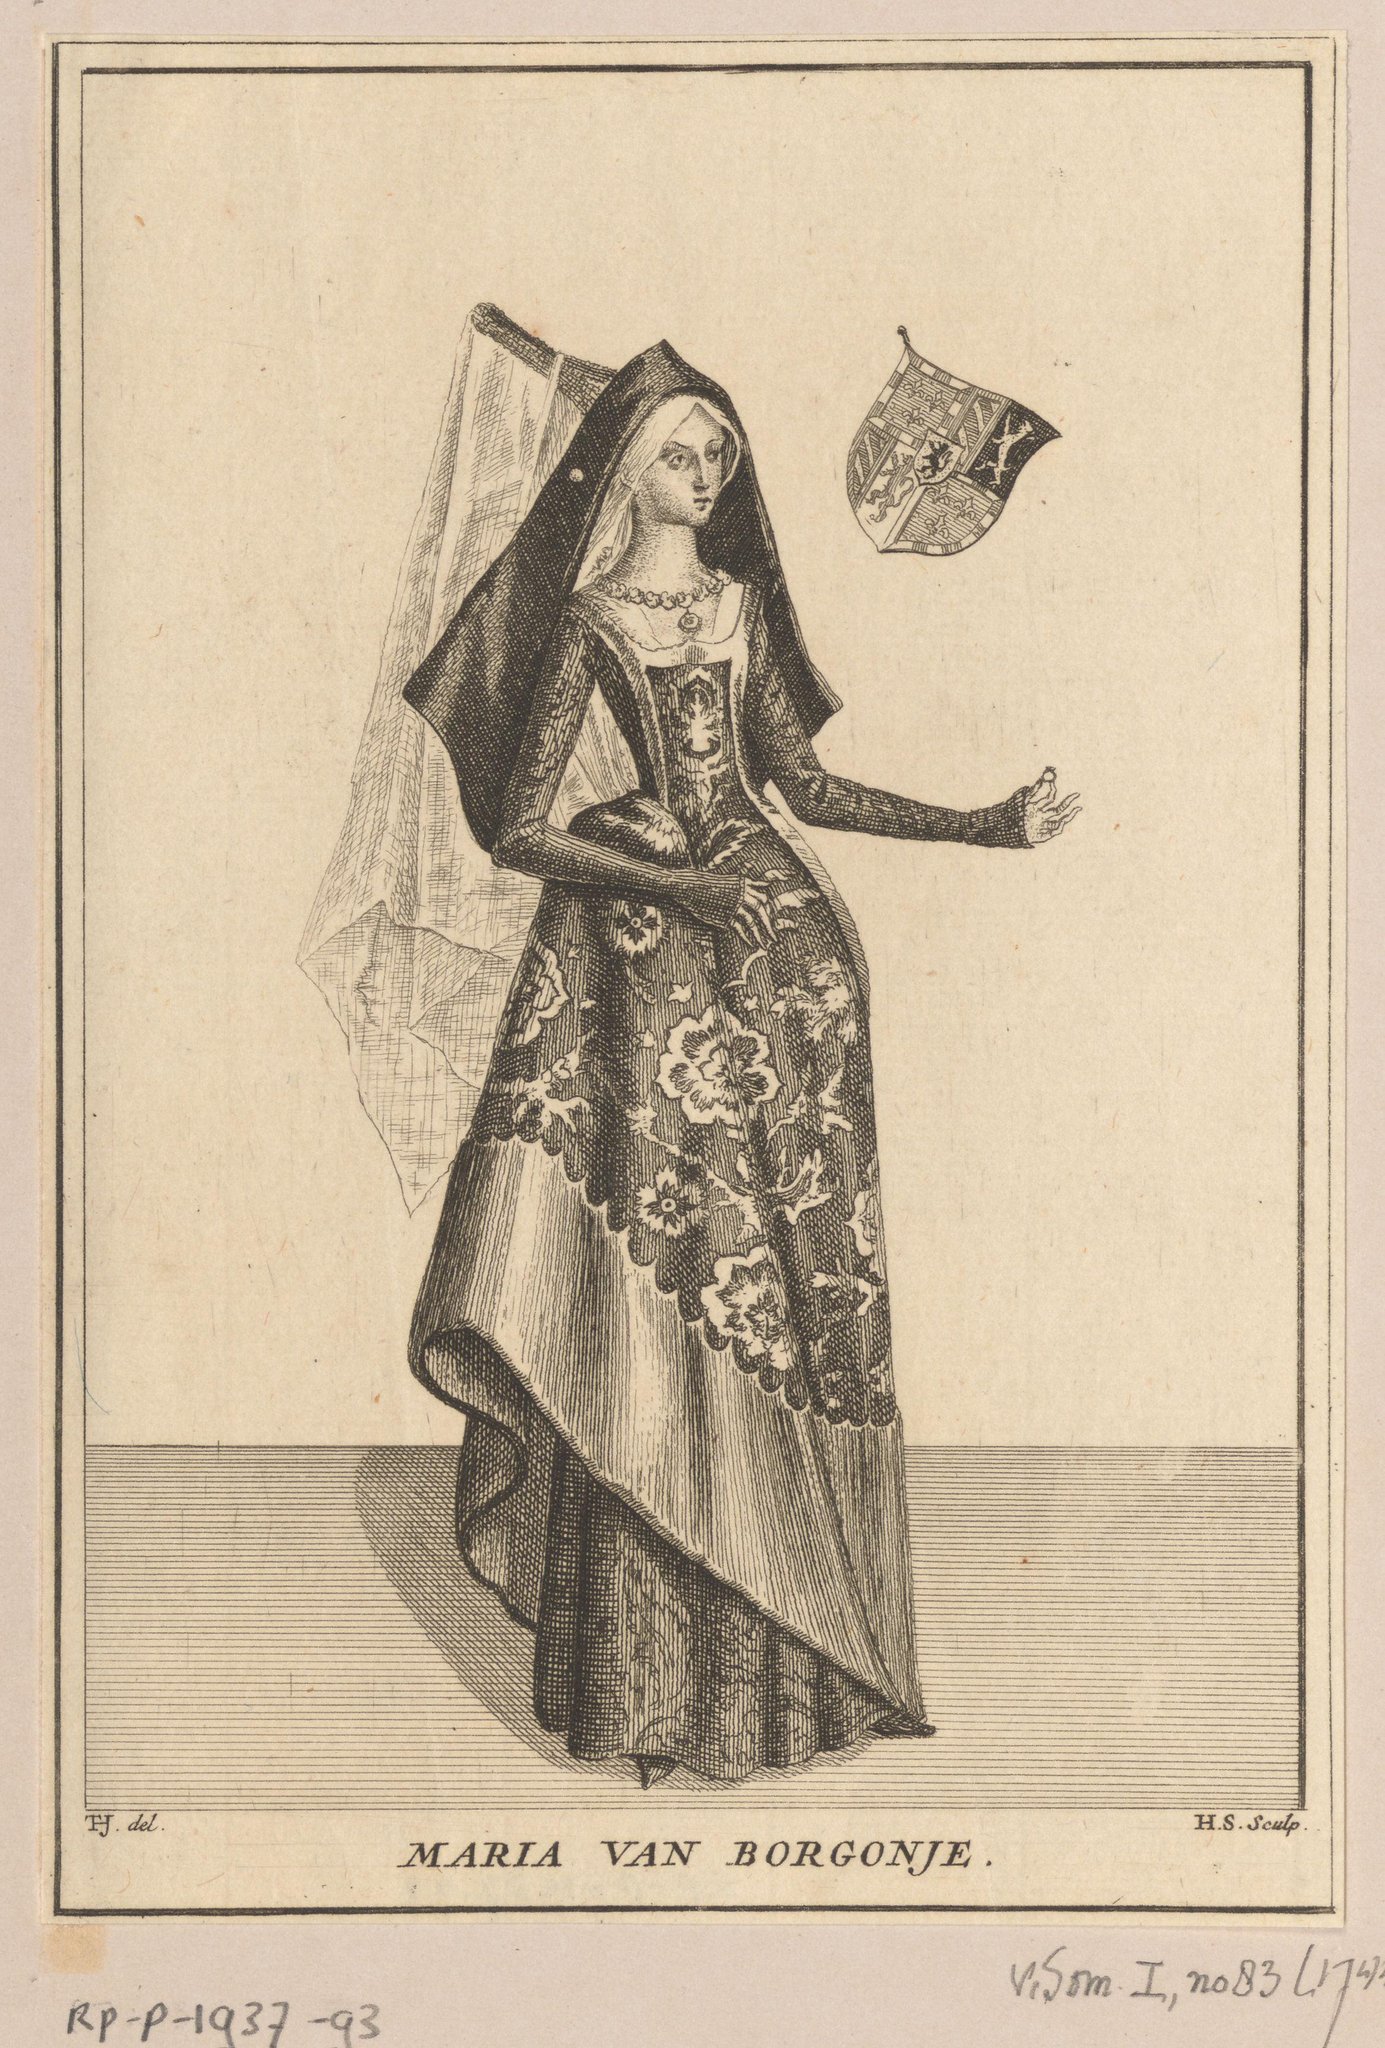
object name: print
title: Portret van Maria van Bourgondië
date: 1745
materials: paper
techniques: etching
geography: haarlem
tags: brussels, bruges, maria (hertogin van bourgondië), historical persons - bb - woman, ruler, sovereign - bb - female ruler, armorial bearing, heraldry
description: Prent waarschijnlijk uit: Langendijk, Pieter. De Graaven van Holland, in jaardichten beschreven door Pieter Langendijk. Verrijkt met alle de beeldtenissen dier prinsen, naauwkeurig getekend naar de echte aloude tafereelen of de zaal van't raadhuis der stad Haarlem. Haarlem: J. Bosch, 1745, dl. 2.